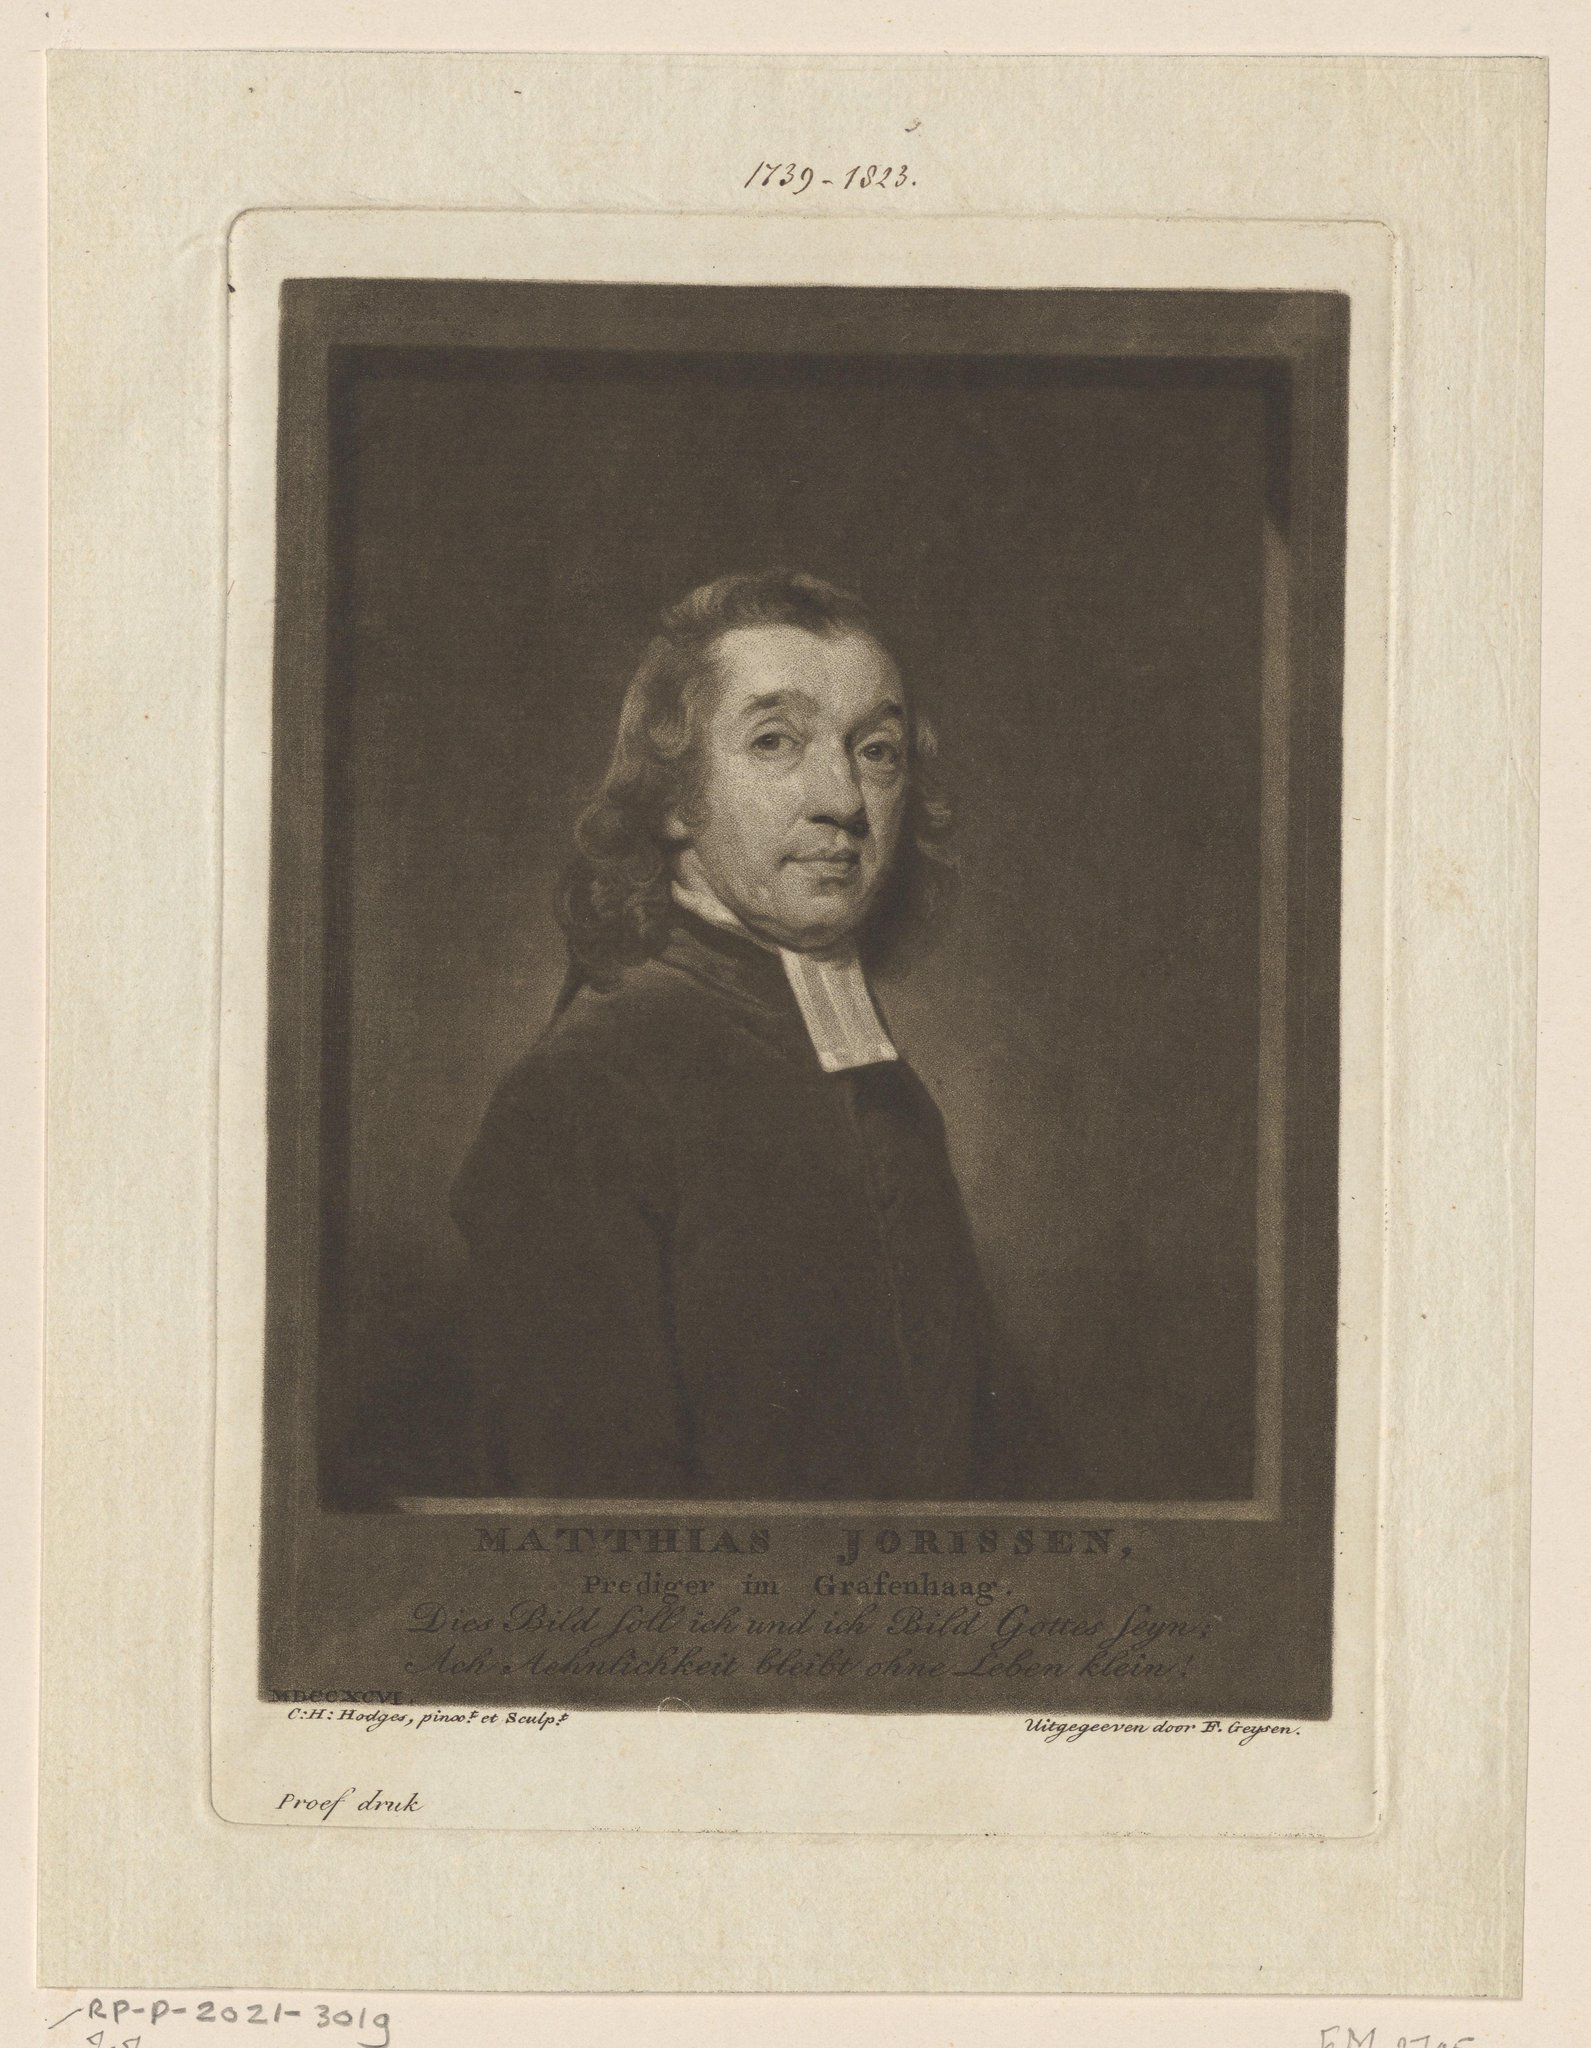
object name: print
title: Portret van Matthias Jorissen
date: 1774-1837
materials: paper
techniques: engraving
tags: the hague, historical persons, christian religion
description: Op verso van deze prent is een tweede blad geplakt met handgeschreven biografische gegevens van de geportretteerde.